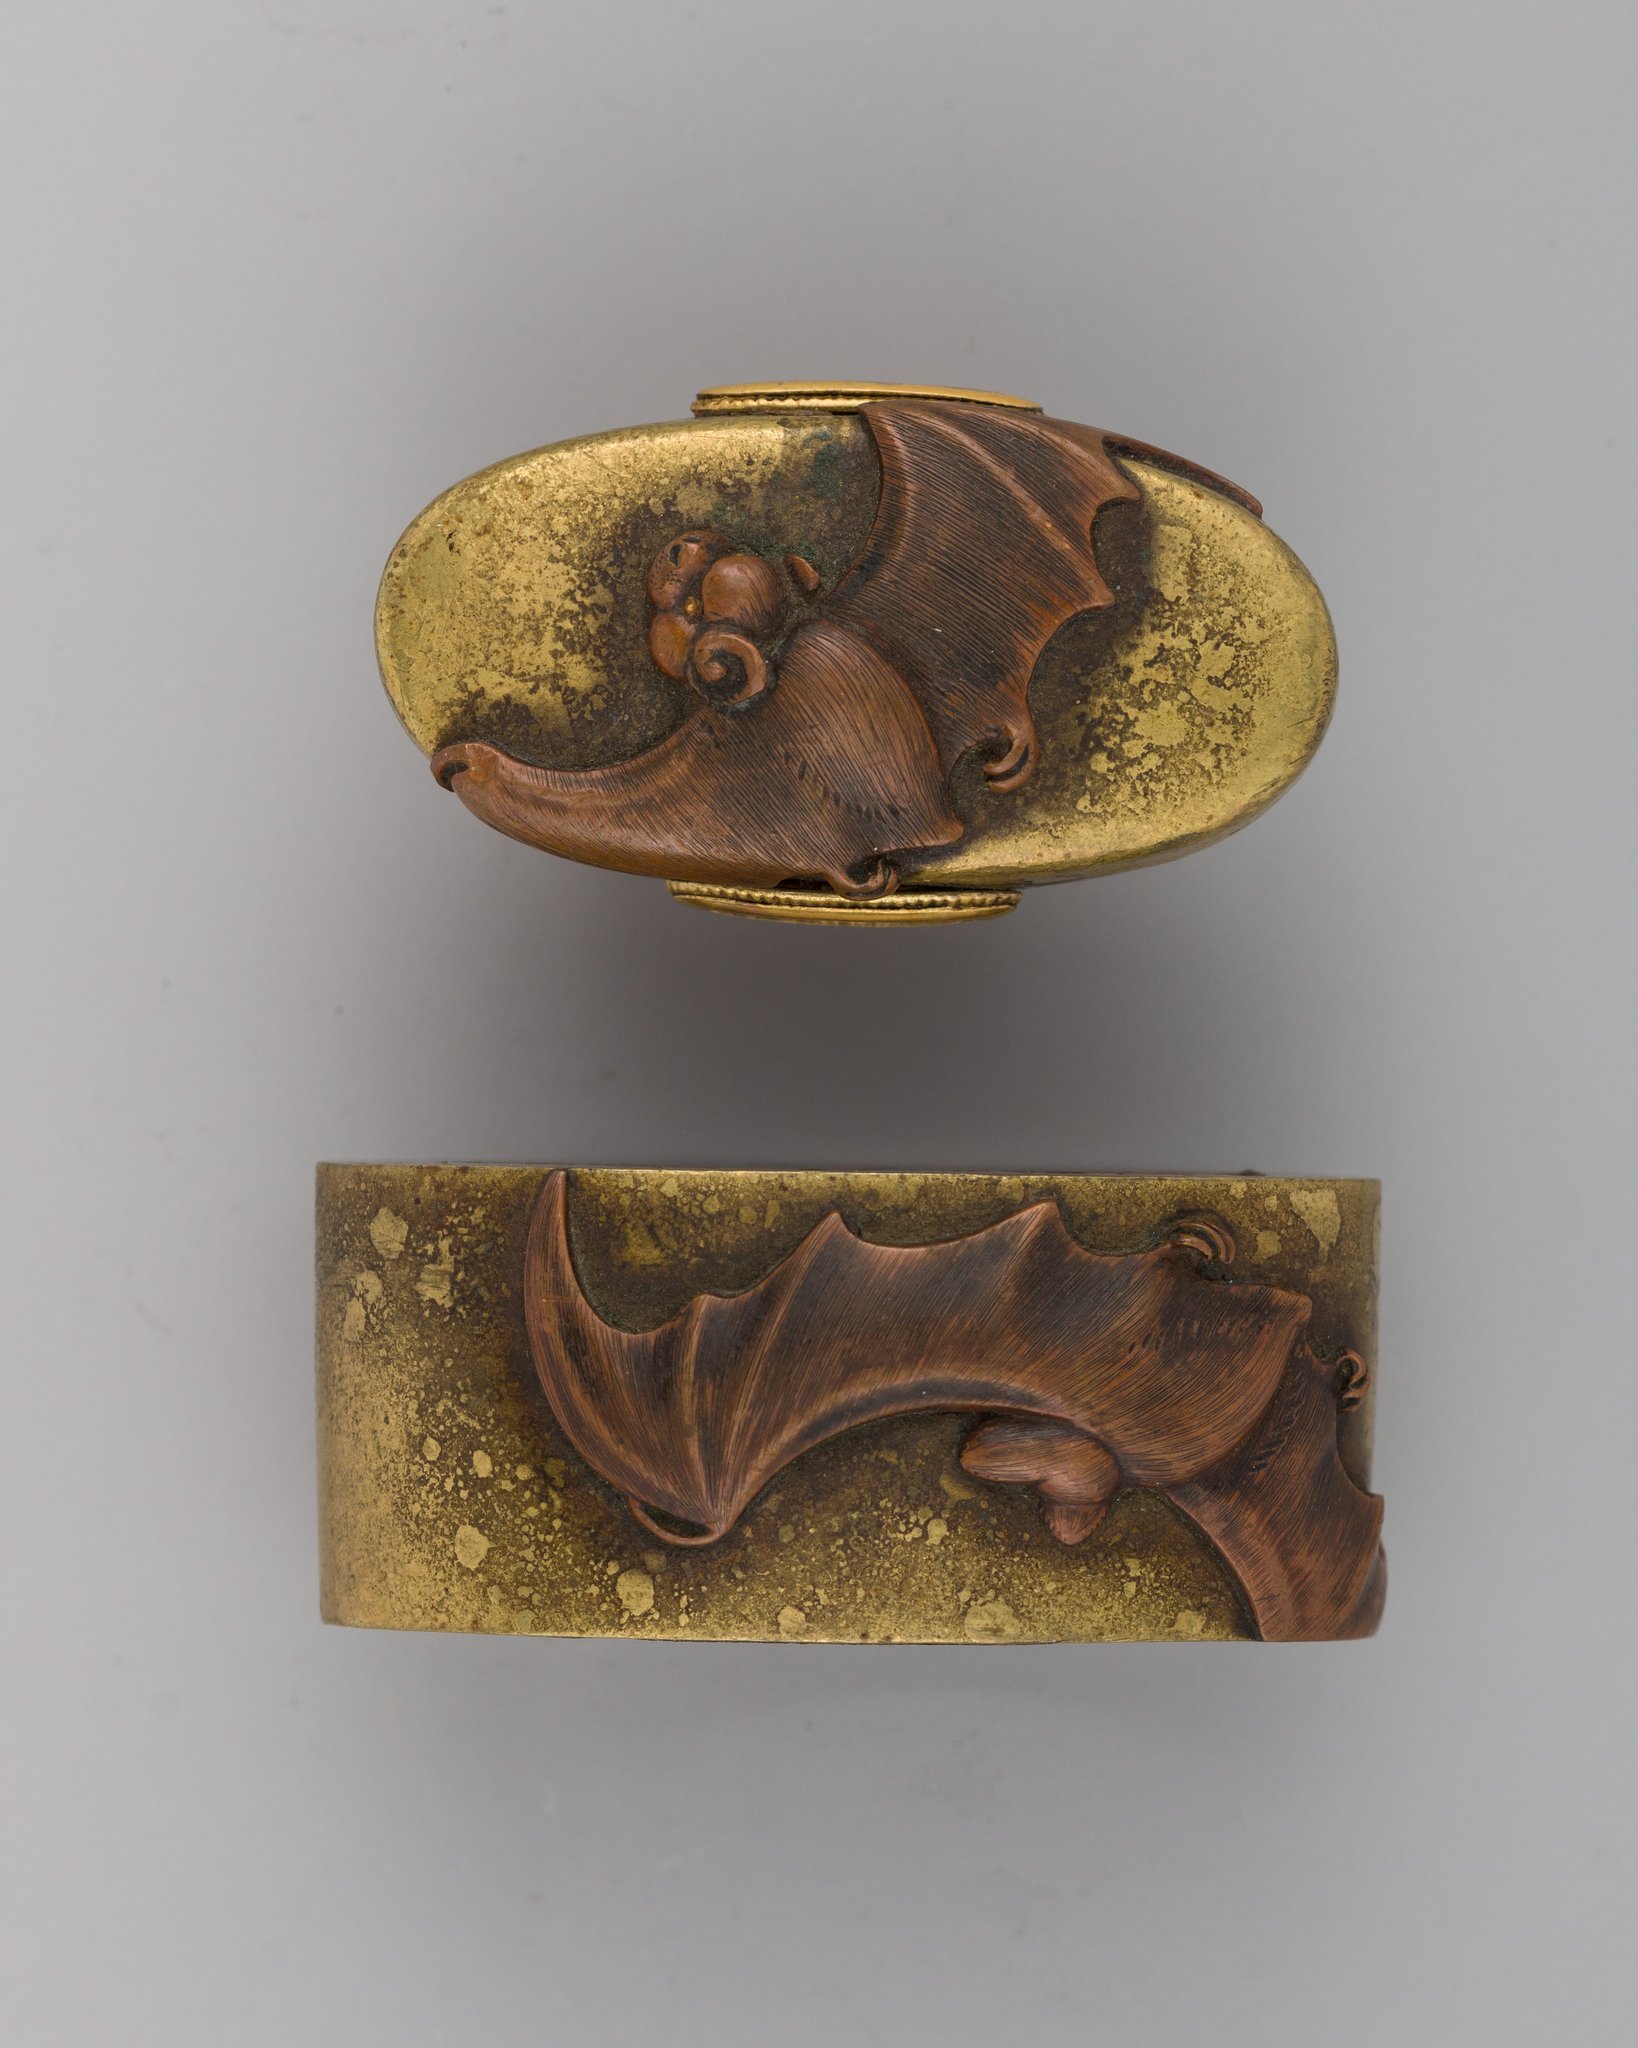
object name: sword hilt collar and pommel fuchigashira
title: Sword-Hilt Collar and Pommel (Fuchigashira)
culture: japanese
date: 1615-1868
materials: copper, copper alloy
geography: japan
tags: bats